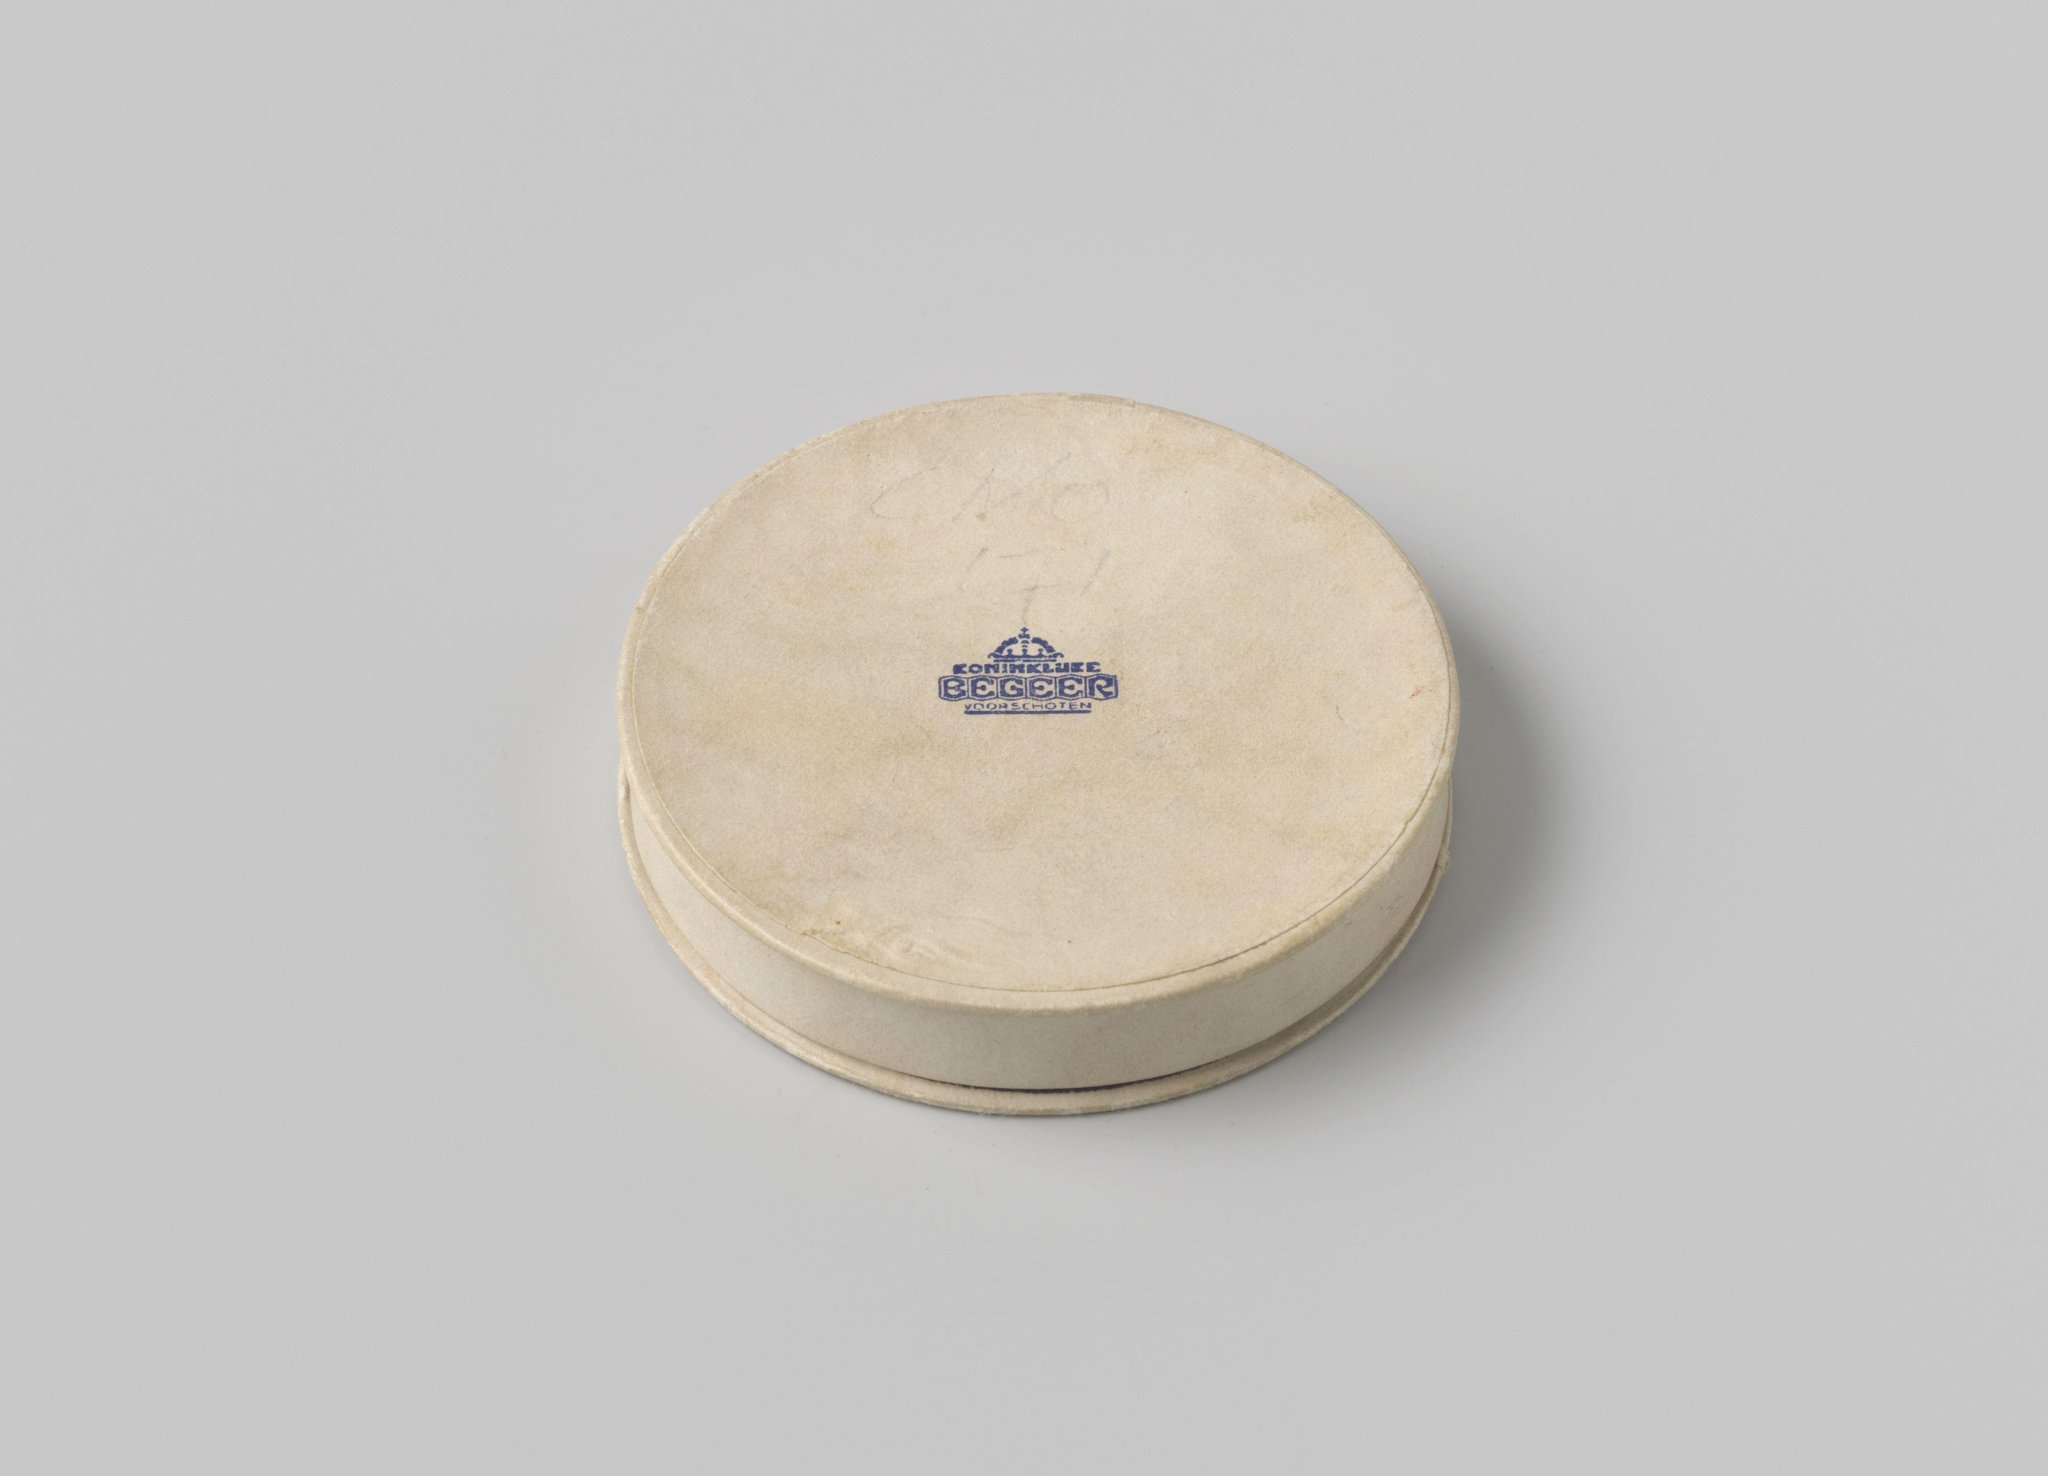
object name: medal box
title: Penningdoos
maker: Anonymous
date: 1957-1958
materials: leather, velvet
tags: surabaya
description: Kartonnen doos, bekleed met paars fluweel. Bijbehorende penning NG-1994-64-1.